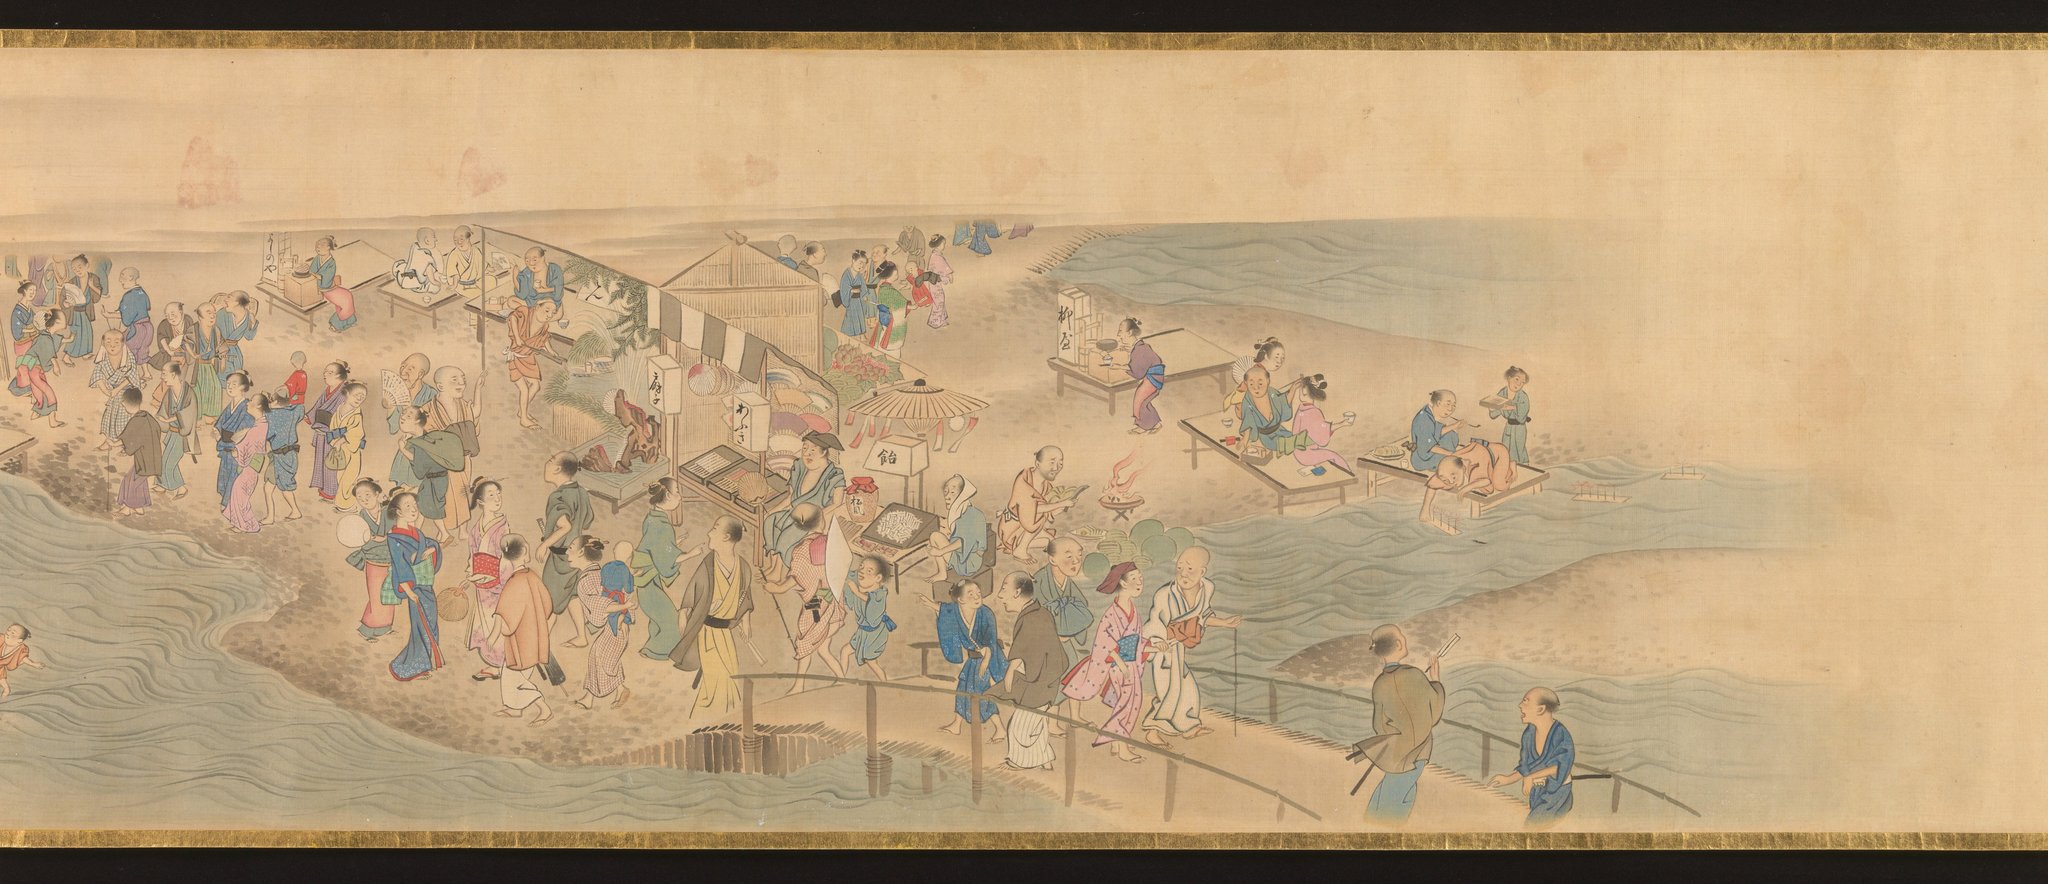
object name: handscroll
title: Scenes of the Four Seasons in Kyoto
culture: japanese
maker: genki (komai ki)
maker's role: artist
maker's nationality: japanese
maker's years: 1747-1797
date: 1778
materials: ink, silk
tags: bridges,men,women,landscapes,daily life,tables